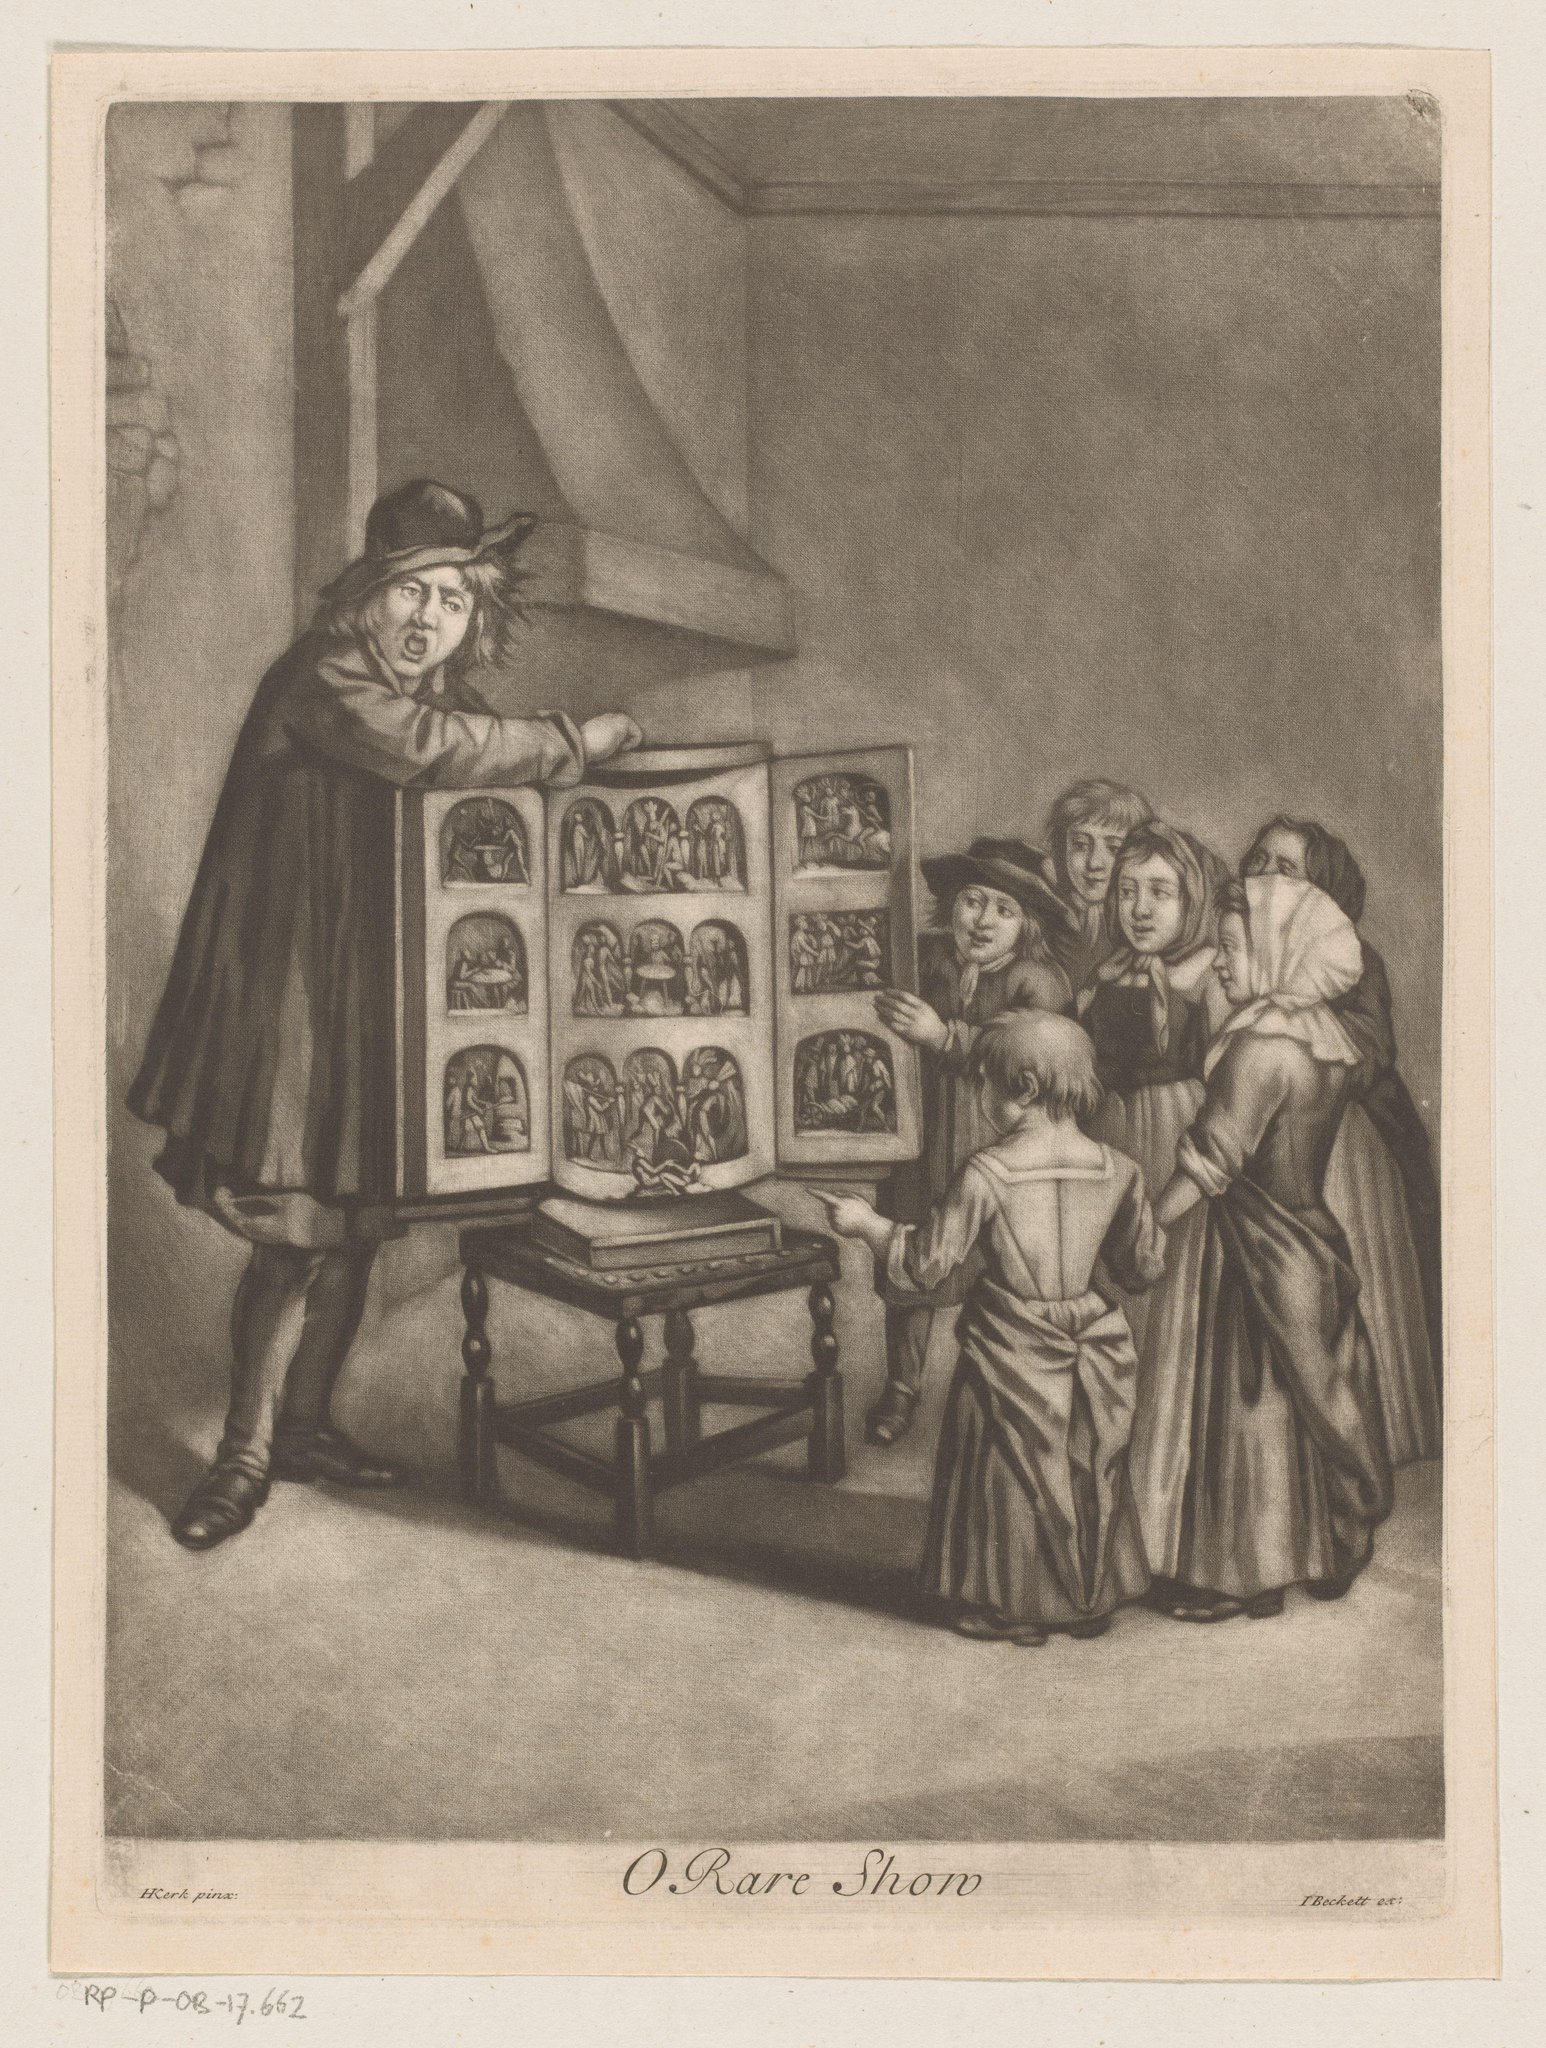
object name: print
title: O Rare Show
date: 1680-1700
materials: paper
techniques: mezzotint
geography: london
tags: children's games and plays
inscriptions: collector's mark: Lugt 240